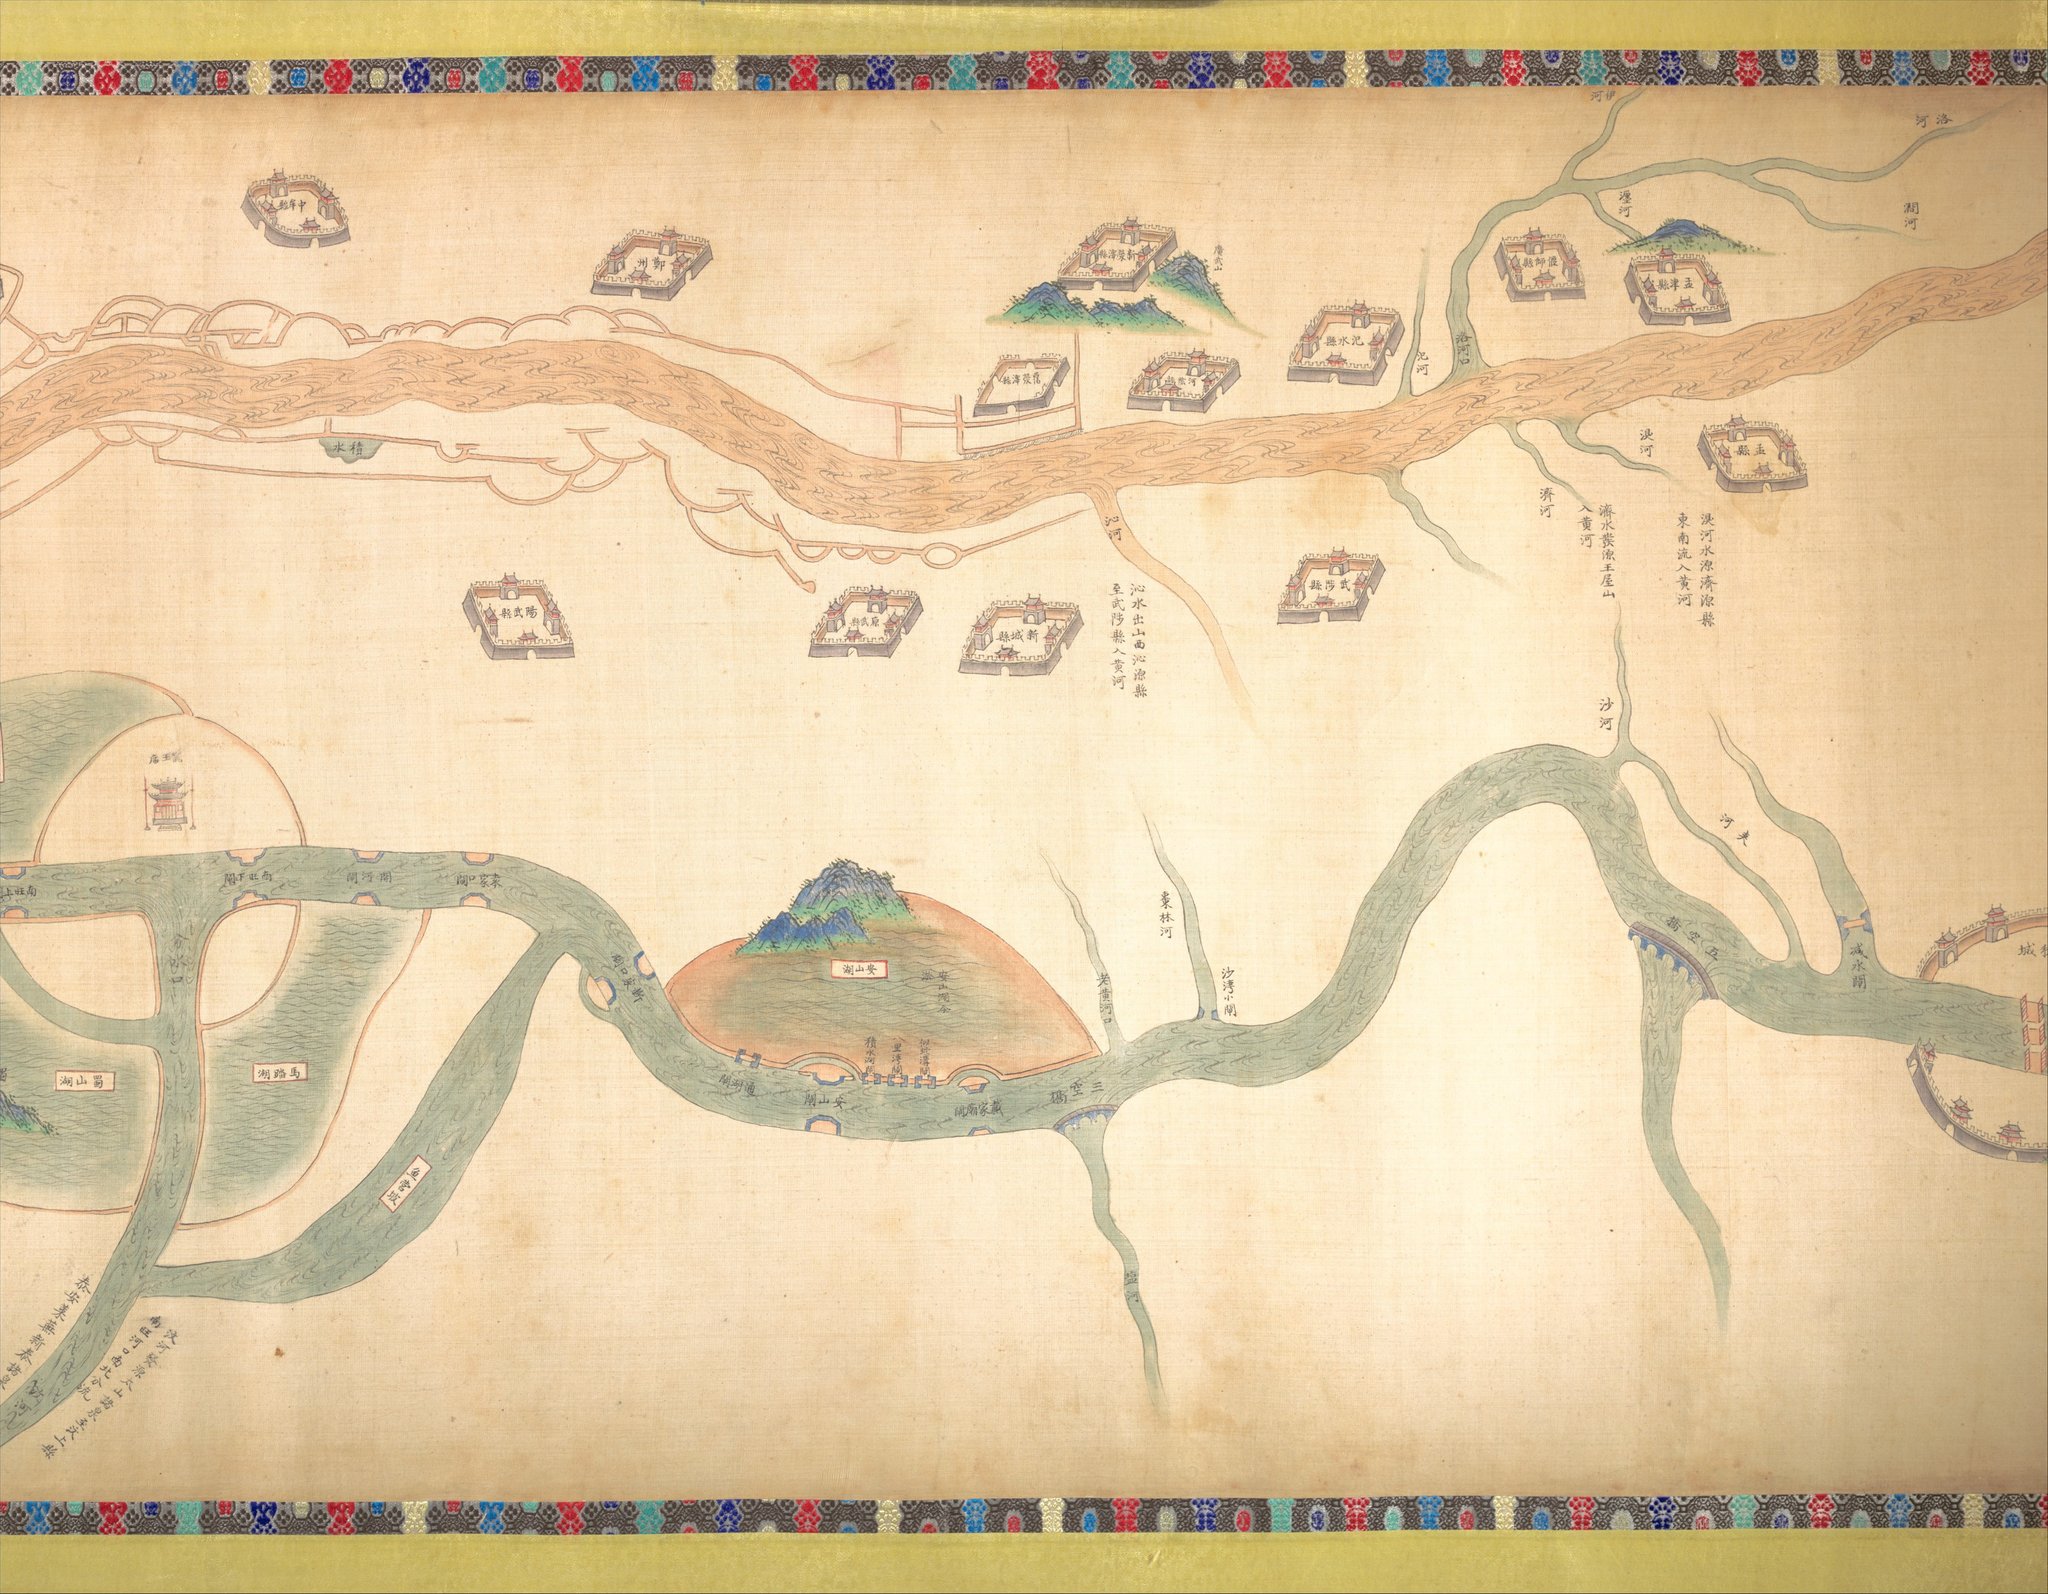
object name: handscroll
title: Map of the Grand Canal from Beijing to the Yangzi River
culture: chinese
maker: unidentified artist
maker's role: artist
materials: ink, silk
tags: canals,maps